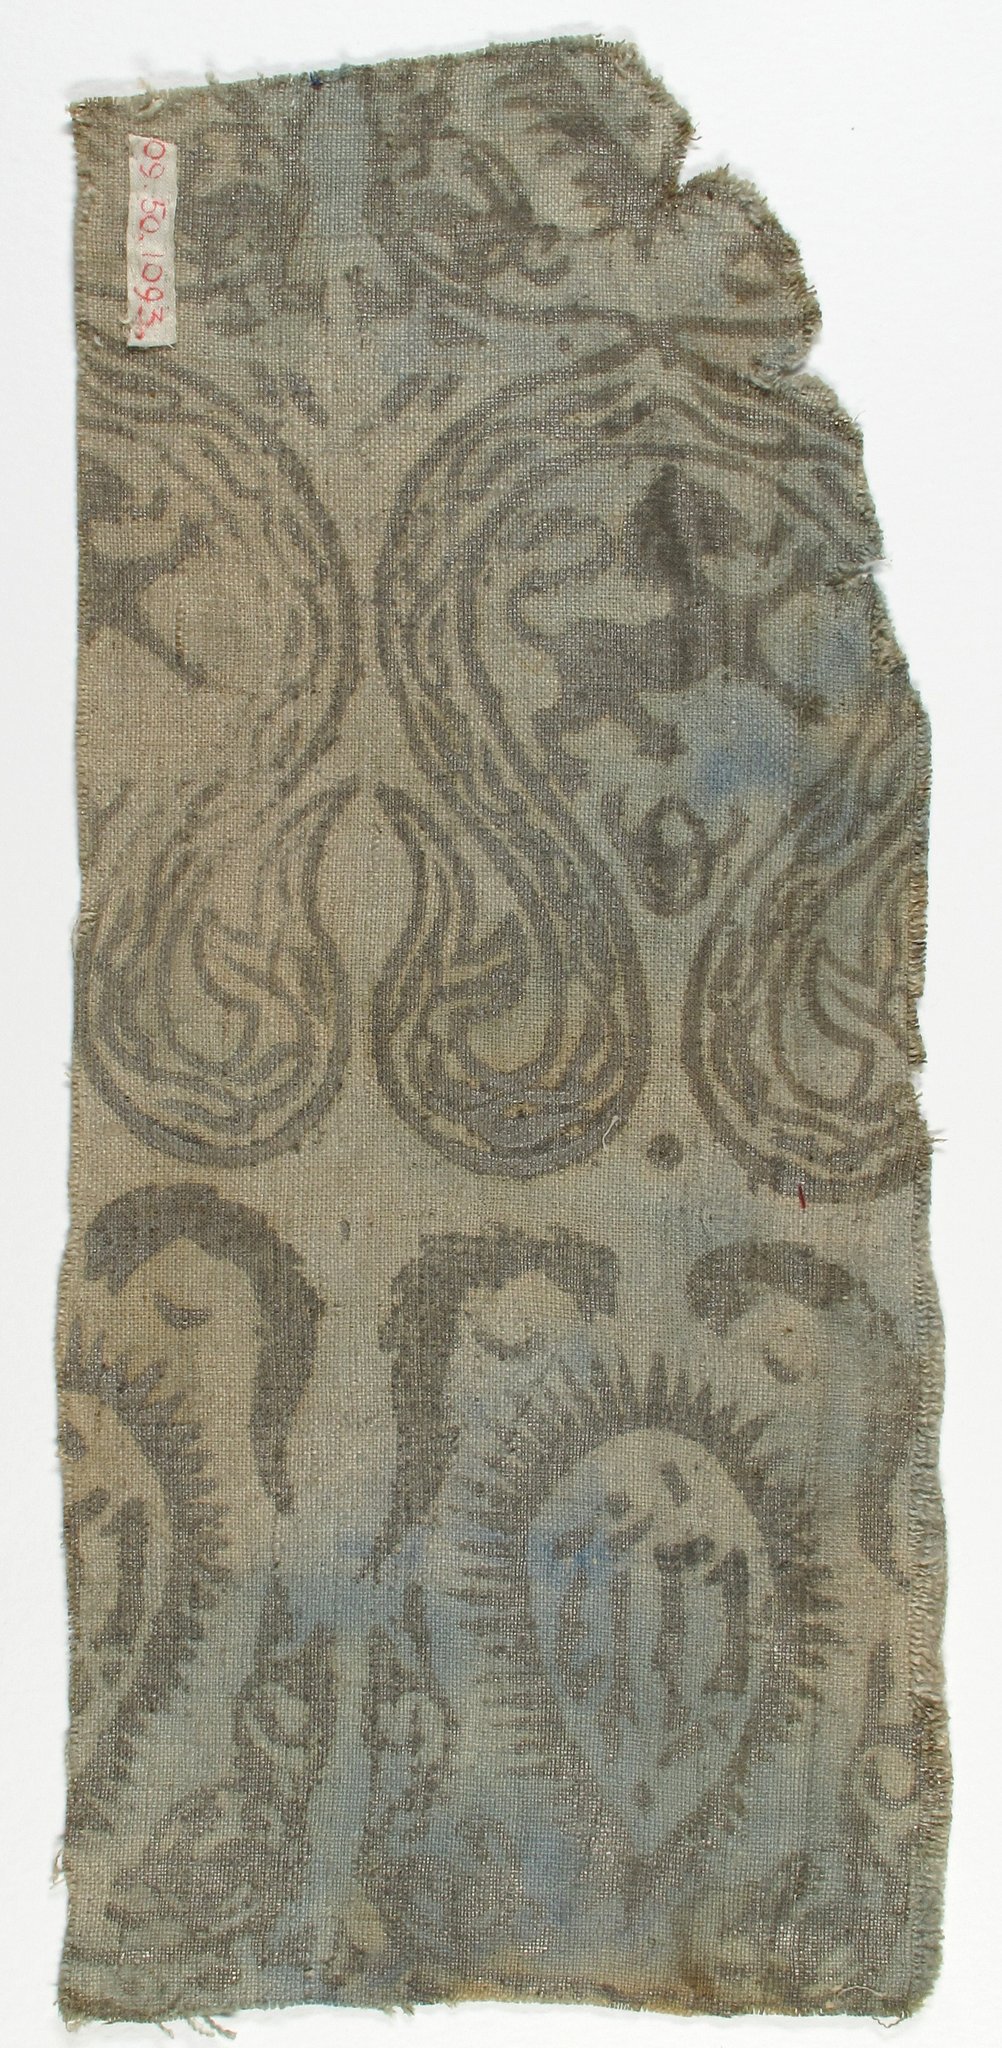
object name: textile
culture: german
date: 1201-1400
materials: linen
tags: lions